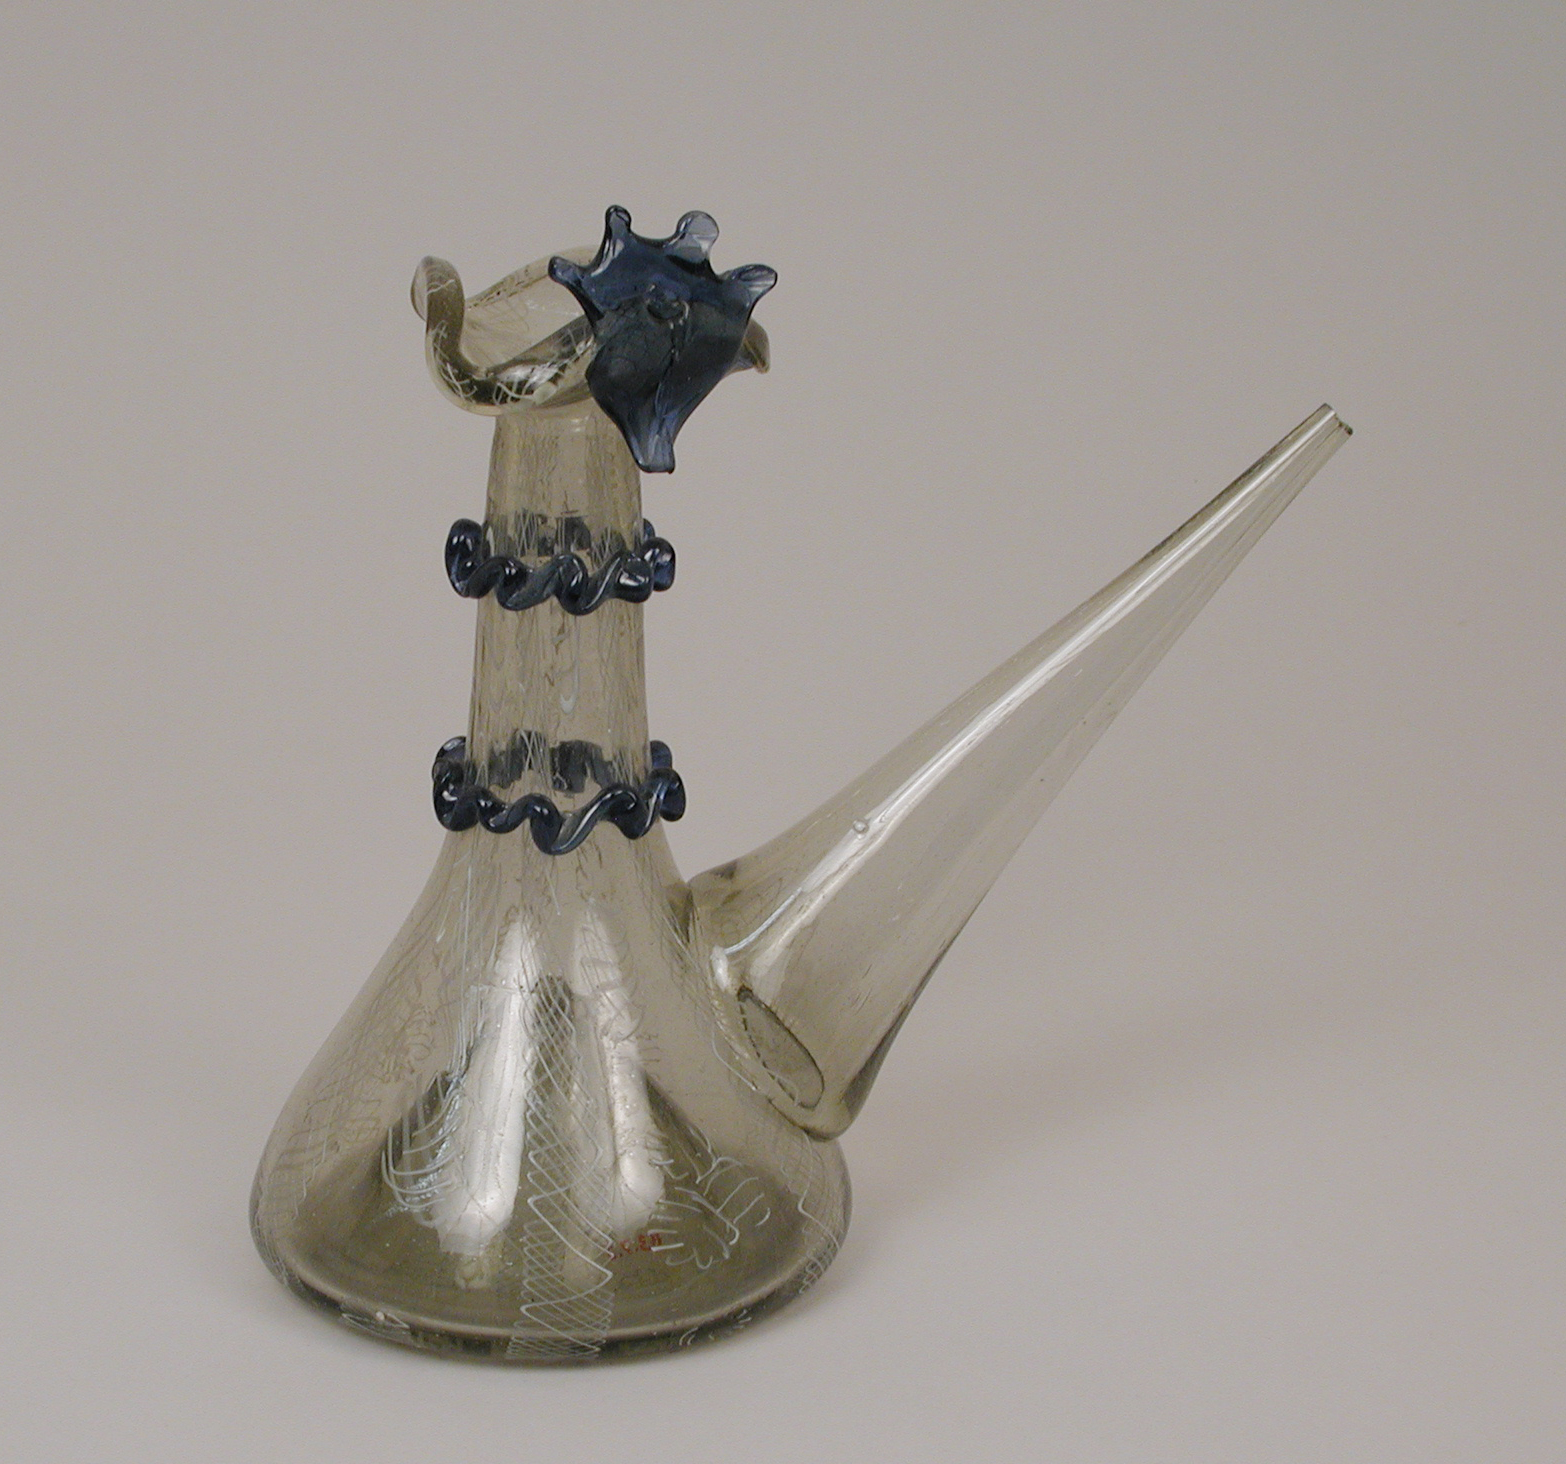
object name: drinking bottle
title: Drinking bottle (Porrón)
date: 1767-1833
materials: glass